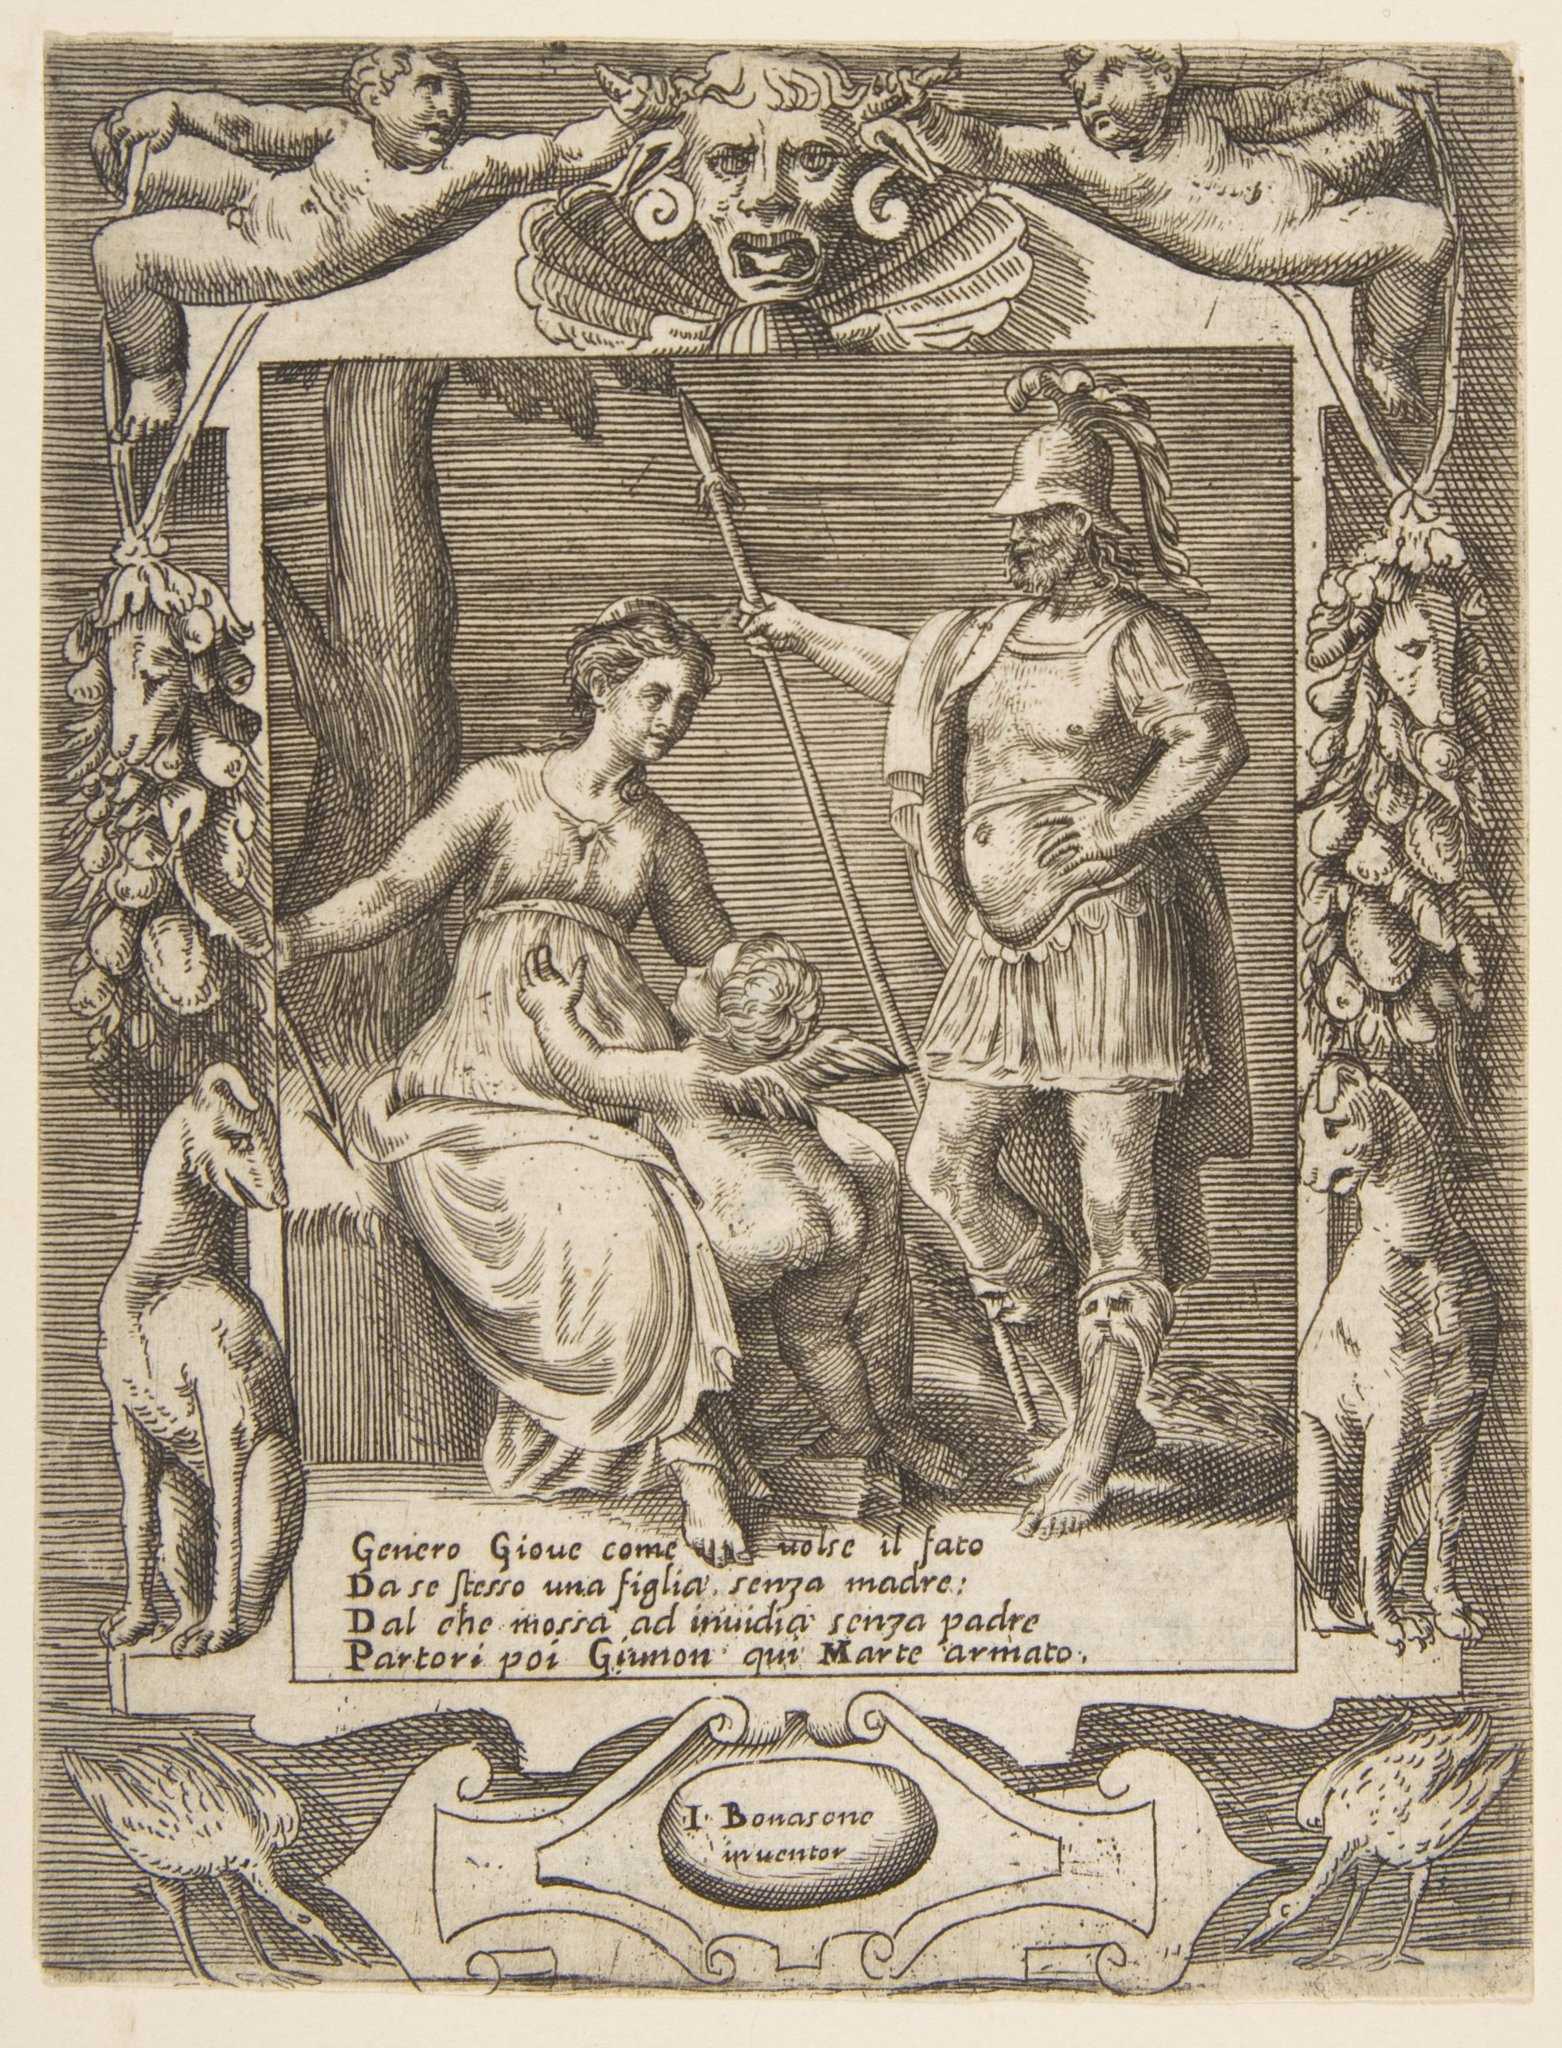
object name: print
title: Juno, Mars and Cupid, set within an elaborate frame, from "Loves, Rages and Jealousies of Juno"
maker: giulio bonasone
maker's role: artist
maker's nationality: italian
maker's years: 1510-1576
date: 1531-1576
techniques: engraving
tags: animals,cupid,juno,mars